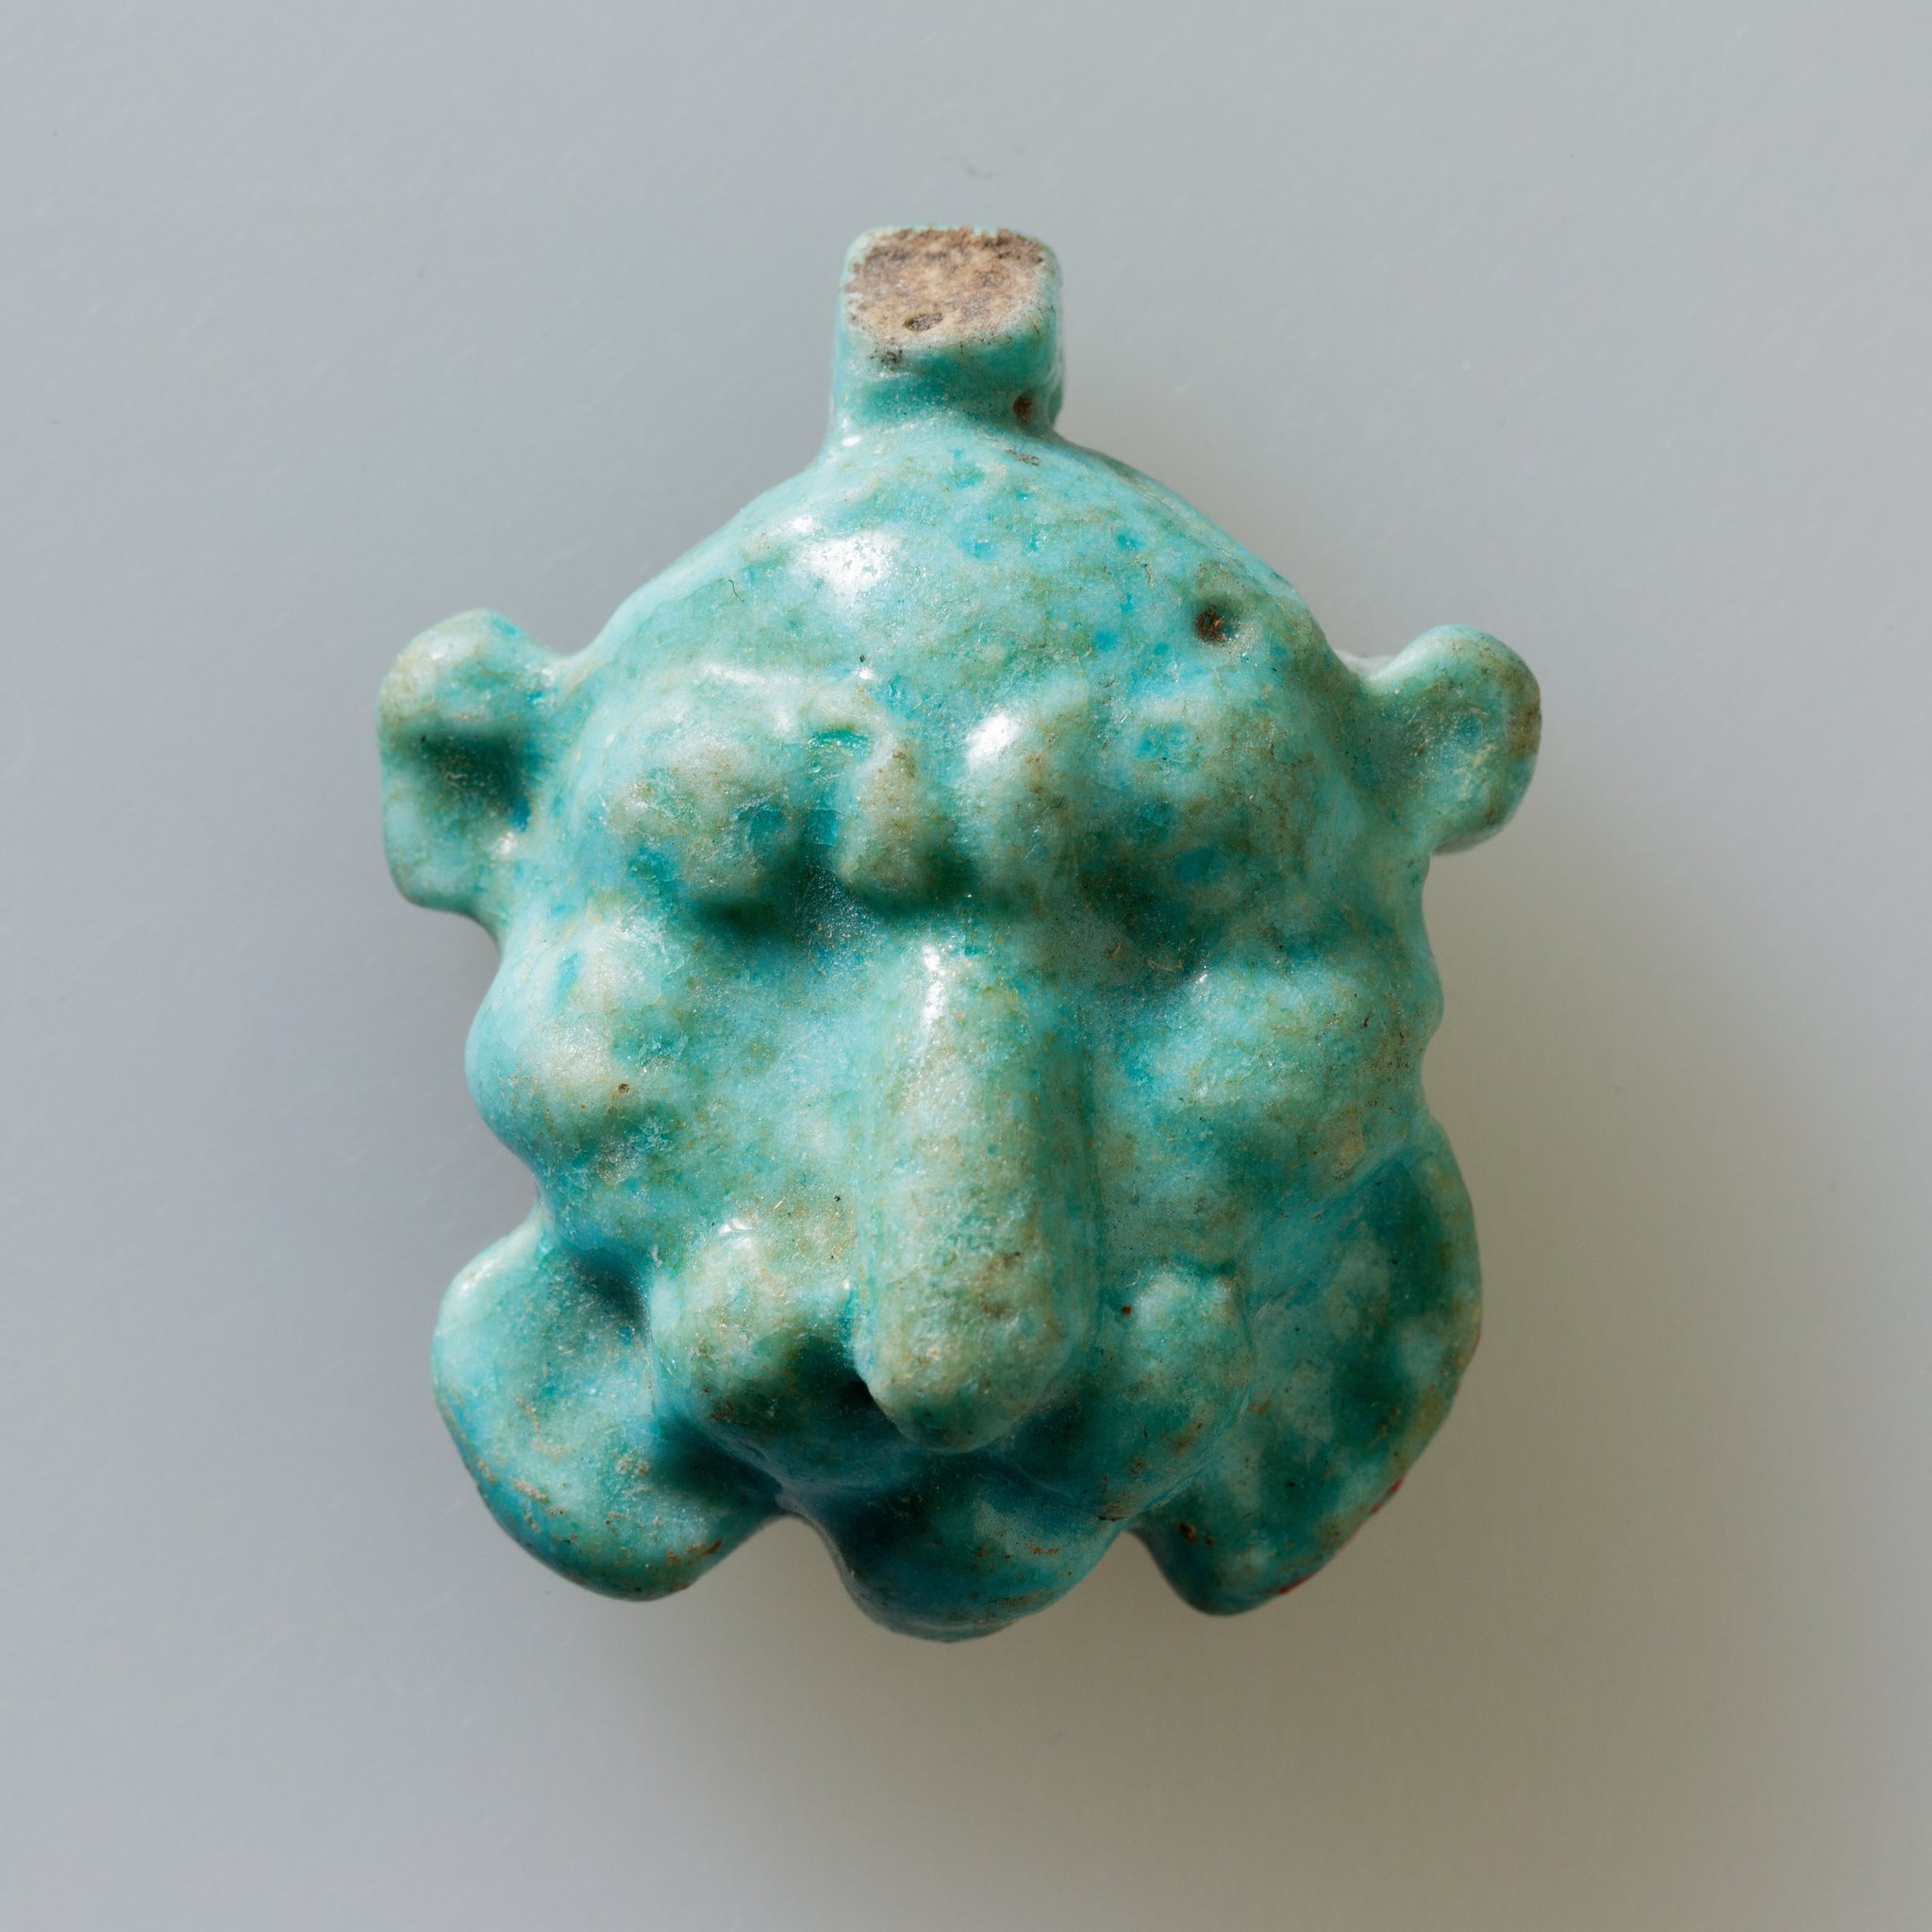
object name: amulet, lion head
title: Lion head amulet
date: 664-630 BCE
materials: faience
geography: egypt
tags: lions